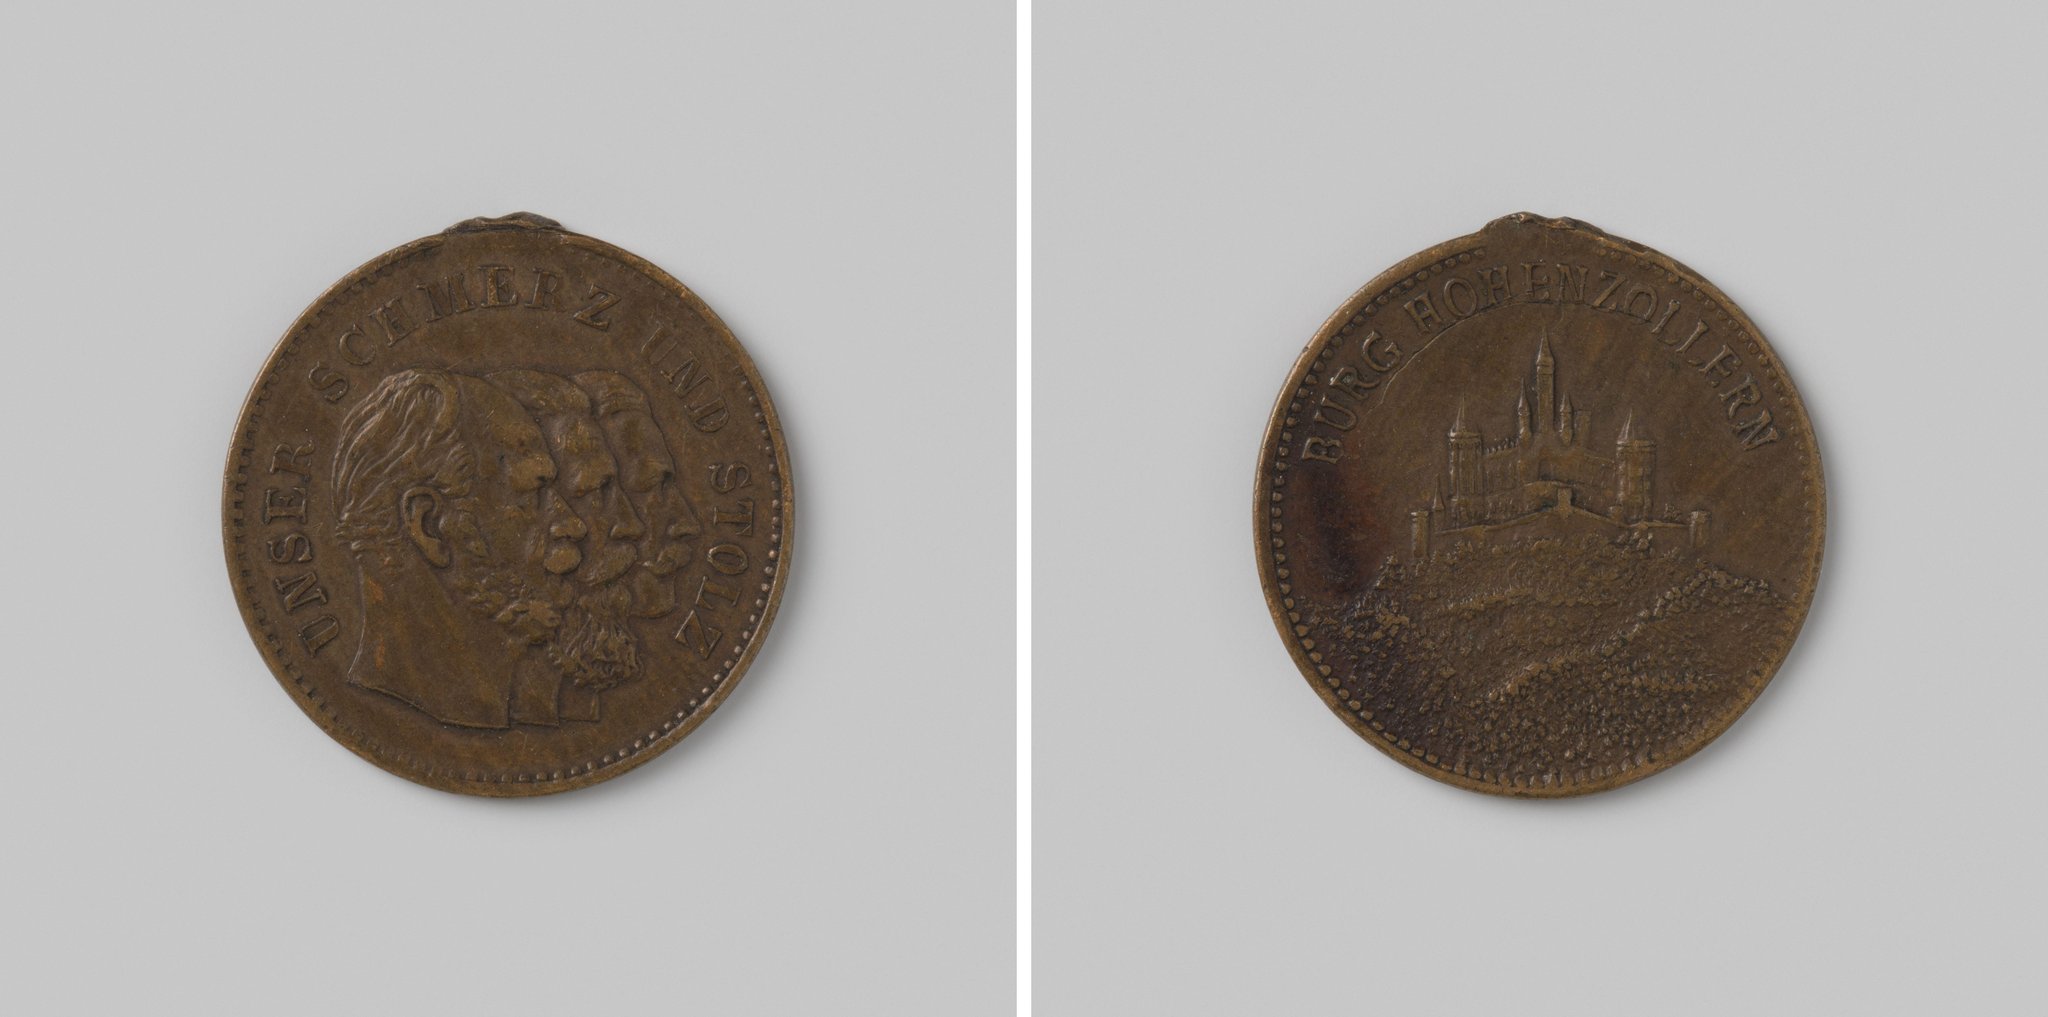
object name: history medal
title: Driekeizerjaar in Duitsland 1888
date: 1888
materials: bronze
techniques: striking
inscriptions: circumscription: ‘UNSER SCHMERZ UND STOLZ’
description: Bronzen penning met verwijderd draagoog, op de voorzijde de geconjugeerde portretten van Wilhelm I, Frederik III en Wilhelm II, met omschrift, op de keerzijde de burgt Hohenzollern op een beboste berg, met bovenaan omschrift.